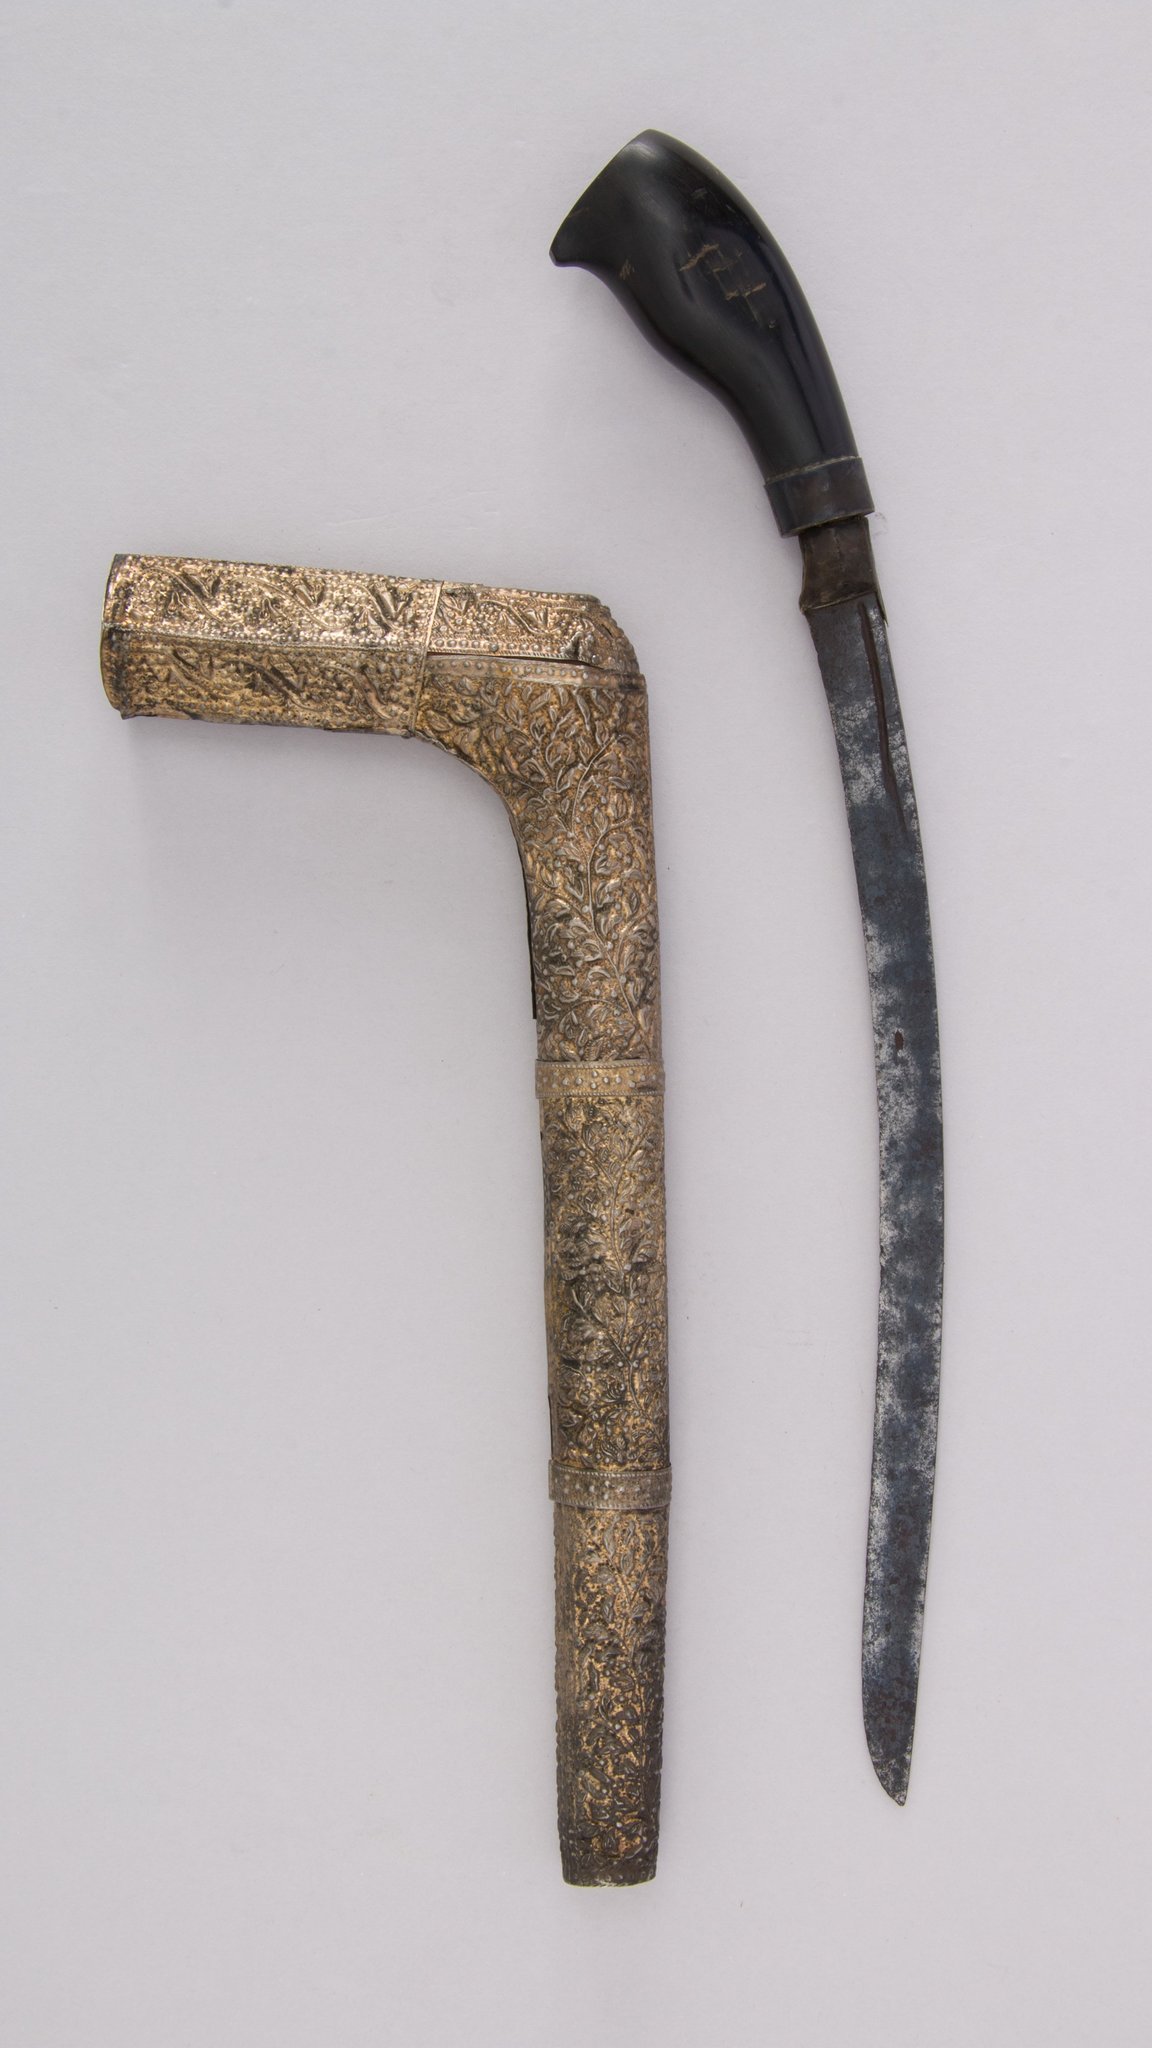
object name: knife bade bade with sheath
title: Knife (Bade-bade) with Sheath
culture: minangkabau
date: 1701-1900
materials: metal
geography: malaysia